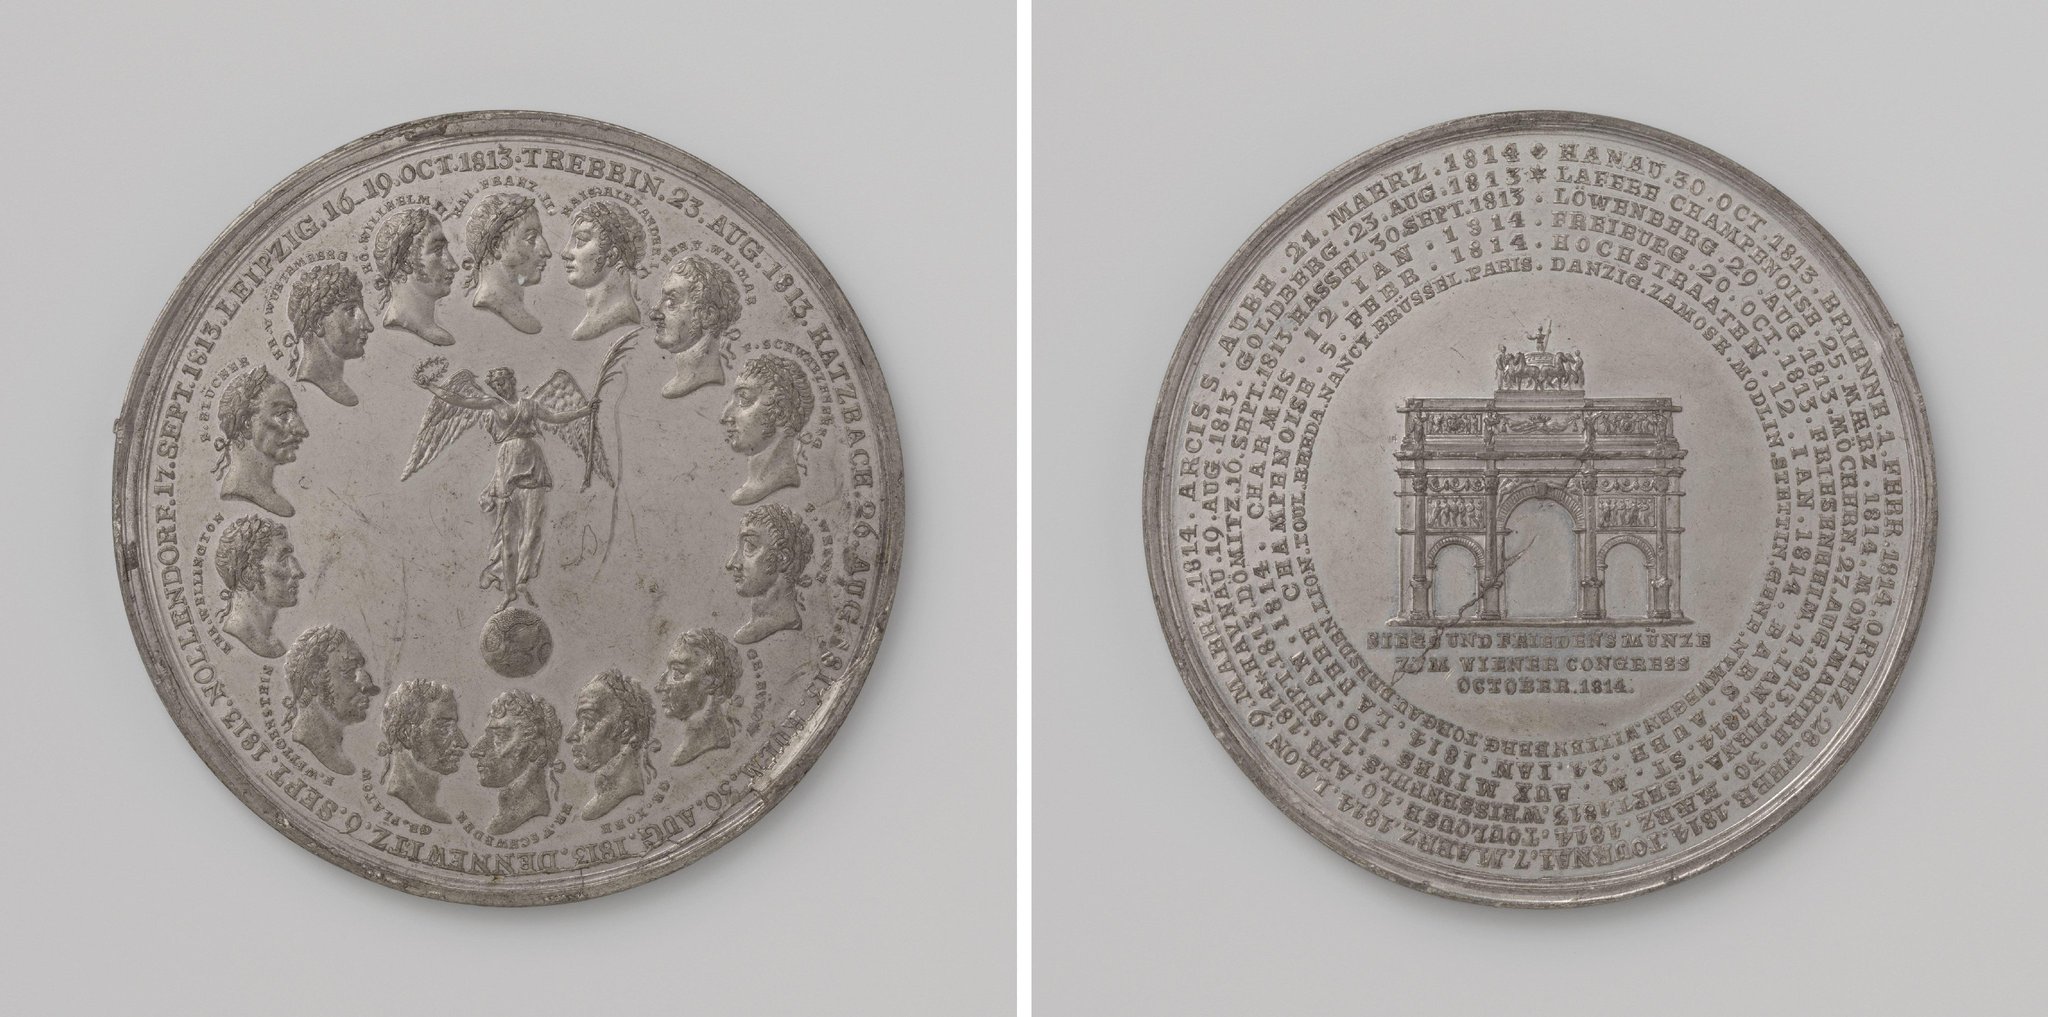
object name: history medal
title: Congres van Wenen met de namen van de belangrijkste veldslagen uit de jaren 1813 en 1814, ter ere van veertien vorsten en veldheren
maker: Anonymous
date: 1814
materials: alloy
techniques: striking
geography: germany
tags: vienna, walmer castle, arthur wellesley of wellington, frans ii (rooms-duits keizer), alexander i (tsaar van rusland), duke of weimar, earl, russia, berlin, frederik willem iii koning van pruisen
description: Penning. Voorzijde: gevleugelde Overwinning met lauwerkrans en palmtak staande op wereldglobe binnen rand van veertien borststukken van mannen met lauwerkransen, ieder met omschrift binnen omschrift. Keerzijde: triomfboog boven opschrift en binnen zesregelig omschrift